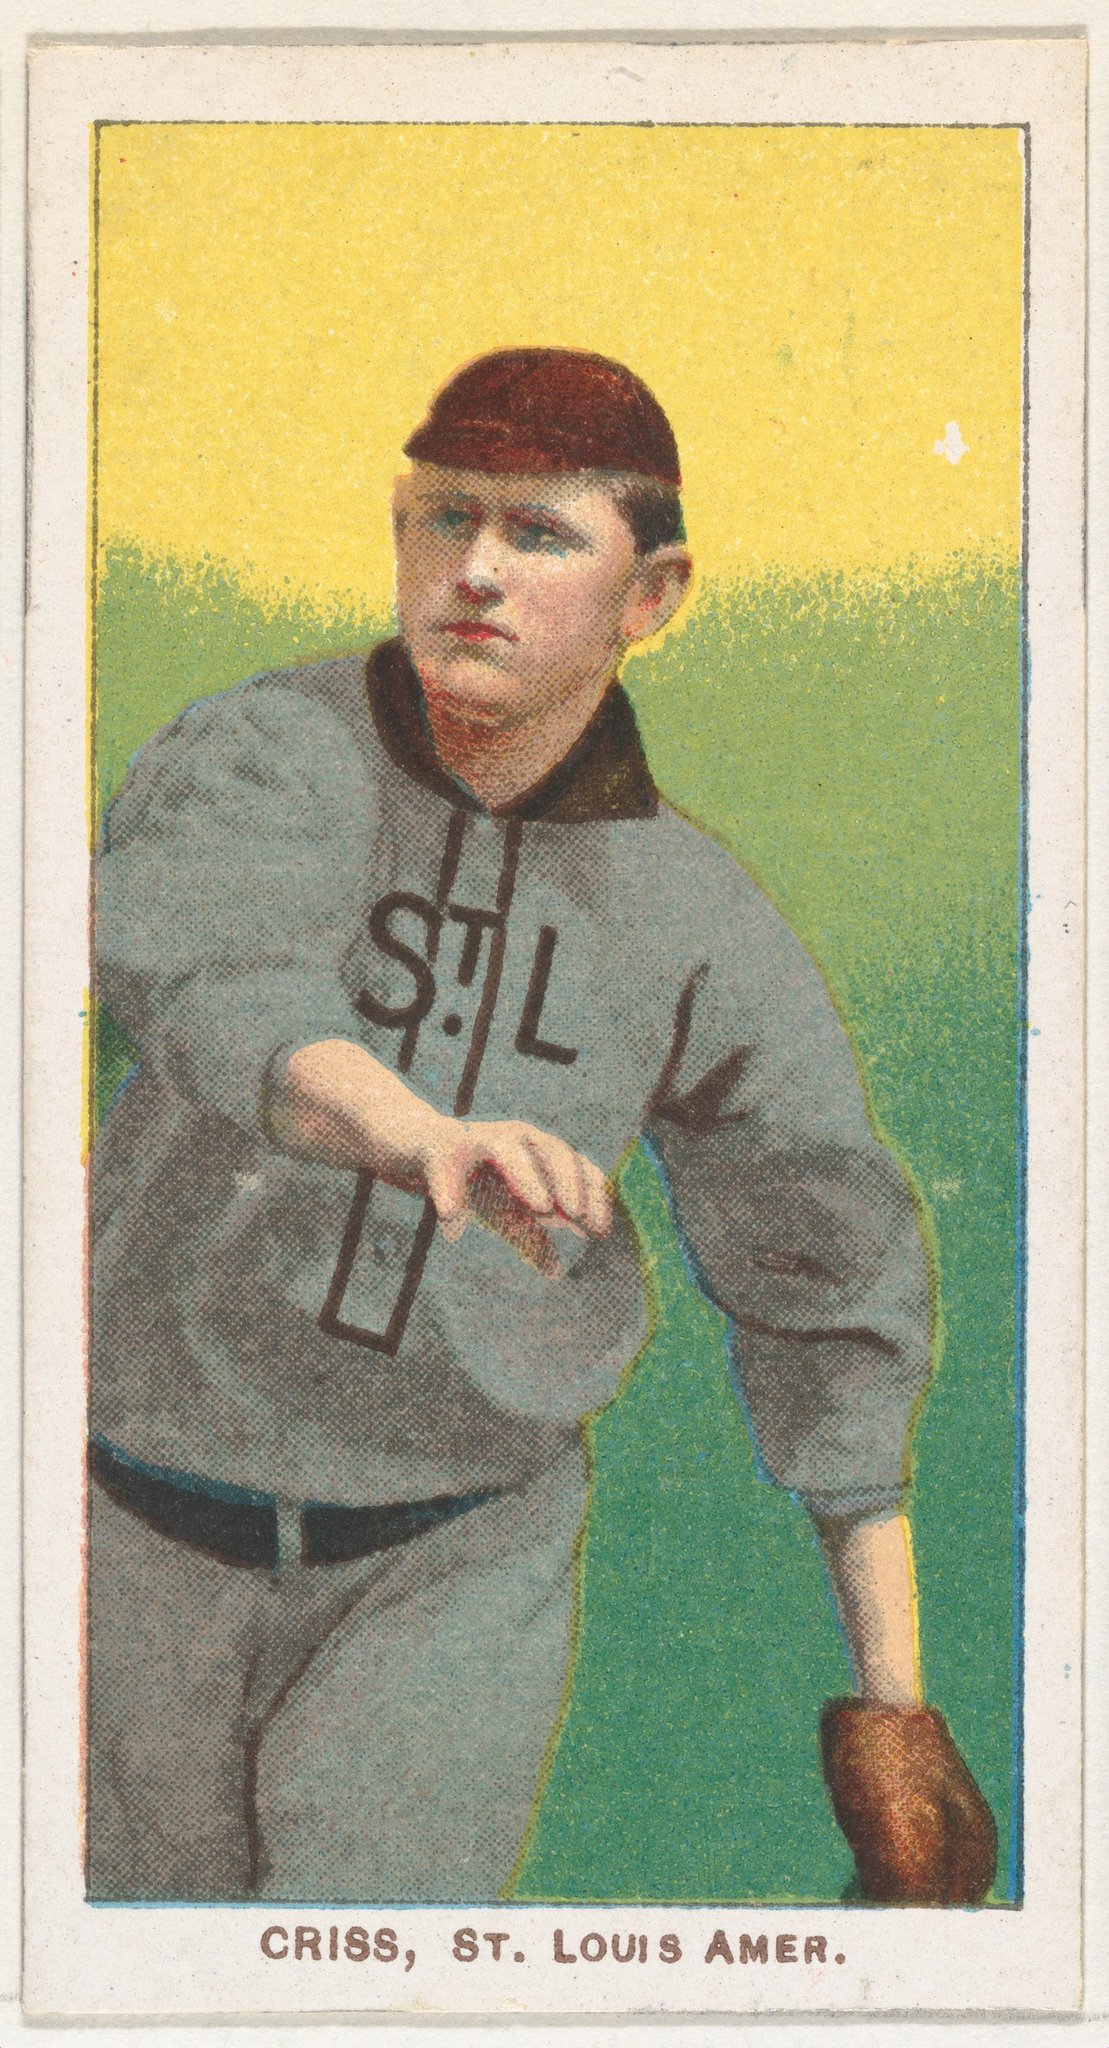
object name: baseball card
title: Criss, St. Louis, American League, from the White Border series (T206) for the American Tobacco Company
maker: american tobacco company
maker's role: publisher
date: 1909-1911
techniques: lithography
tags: men,portraits,baseball,athletes